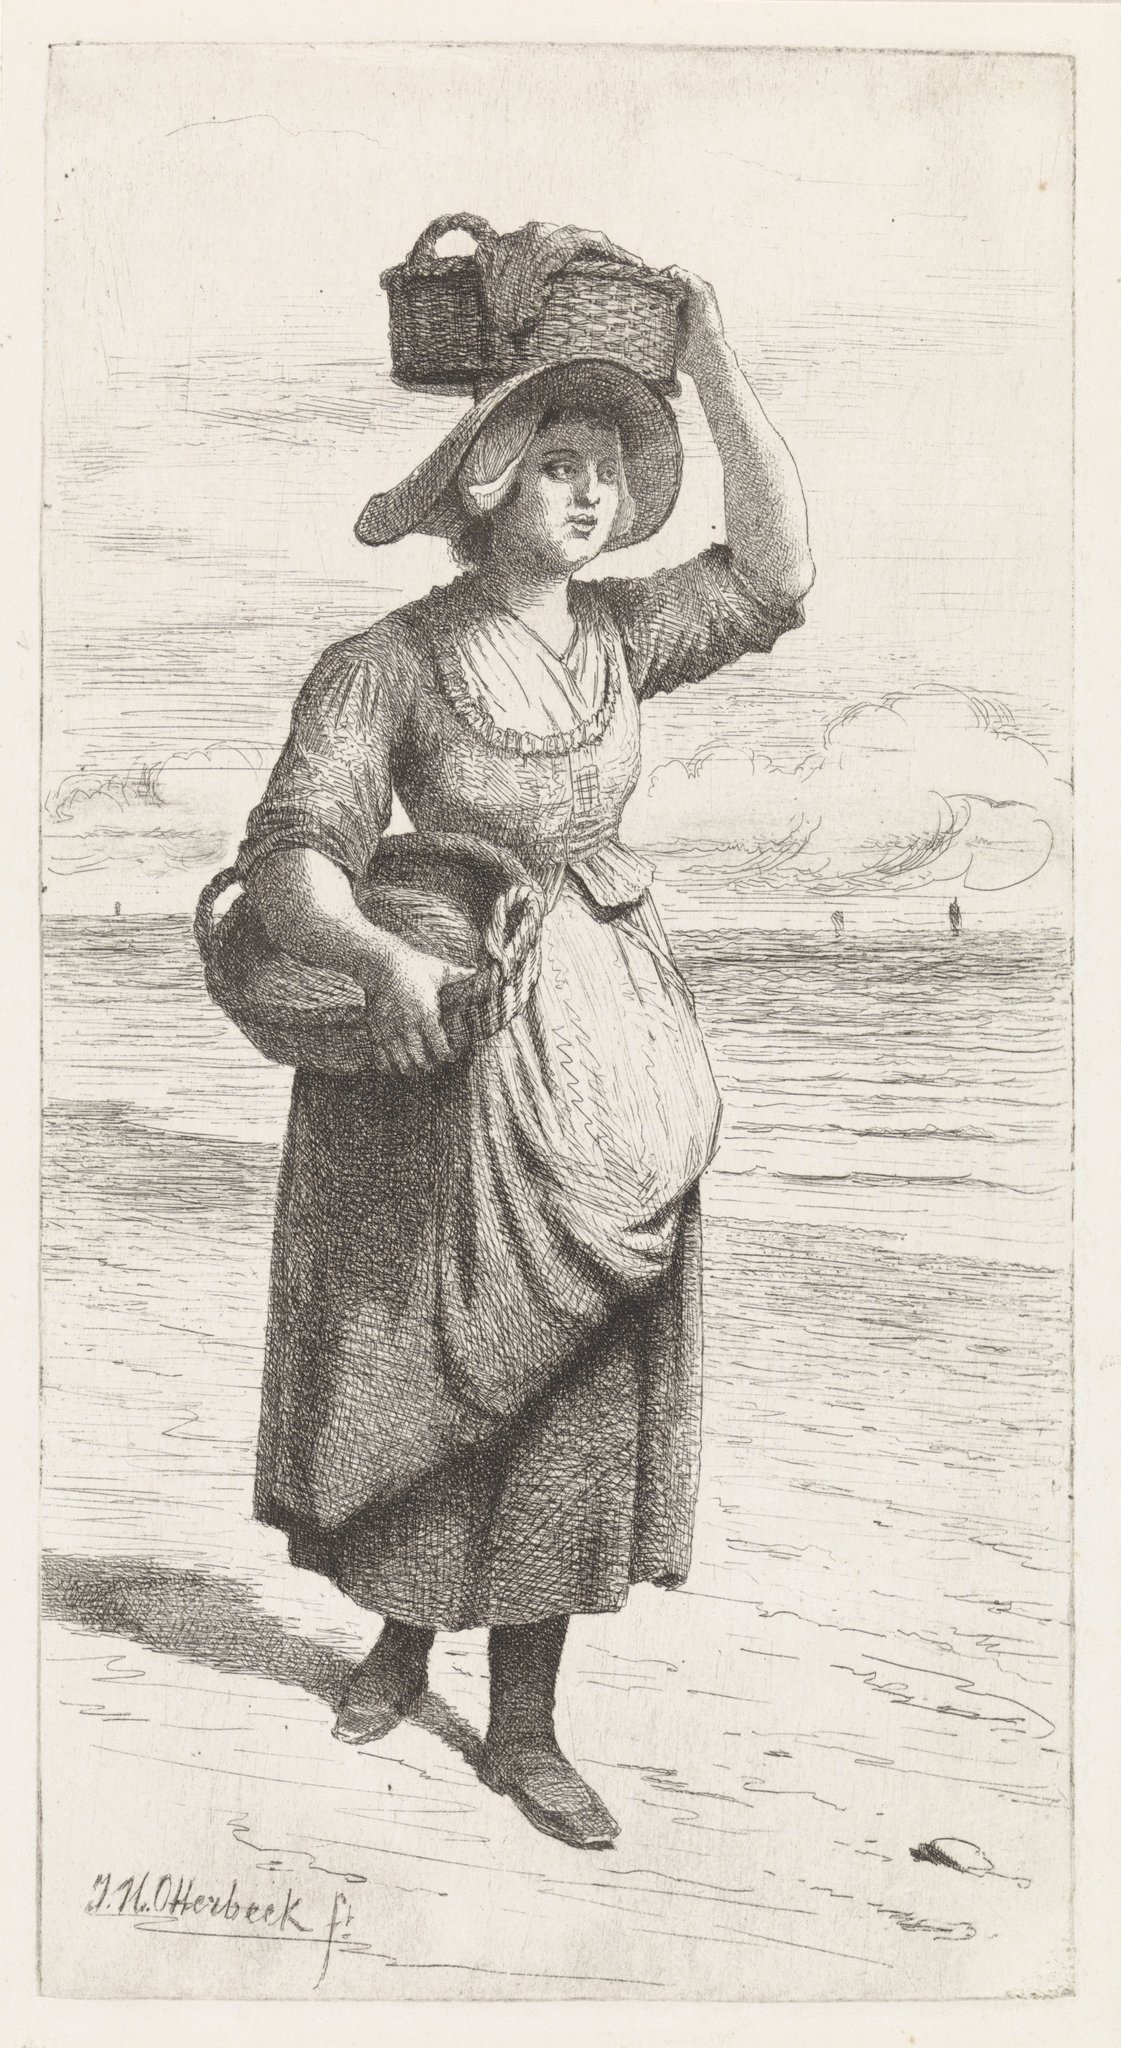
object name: print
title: Vrouw met manden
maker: jacobus hermanus otterbeek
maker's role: painter, print maker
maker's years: 1839-1902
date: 1854-1902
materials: paper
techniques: etching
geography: the hague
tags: carrying something in basket, bag, rucksack, etc.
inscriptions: collector's mark: Lugt 2228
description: Een vrouw loopt op het strand. Ze draagt een mand onder haar arm en eentje op haar hoofd.